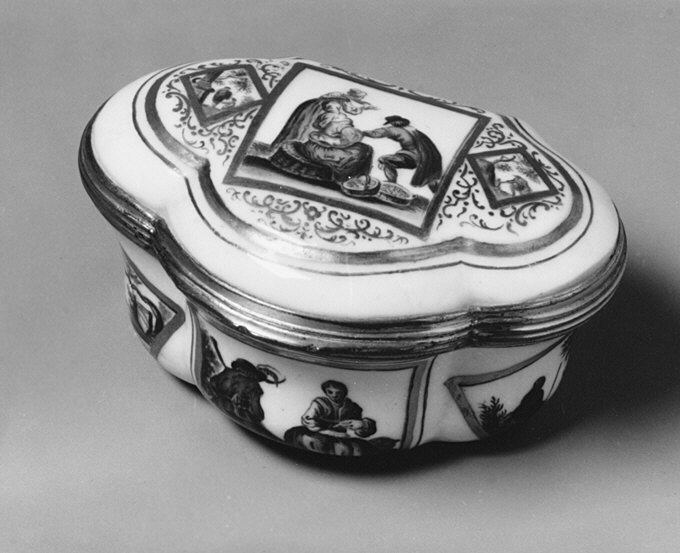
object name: snuffbox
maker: doccia porcelain manufactory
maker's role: manufactory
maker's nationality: italian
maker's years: 1737-1896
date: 1750-1755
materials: gold, hard paste porcelain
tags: human figures